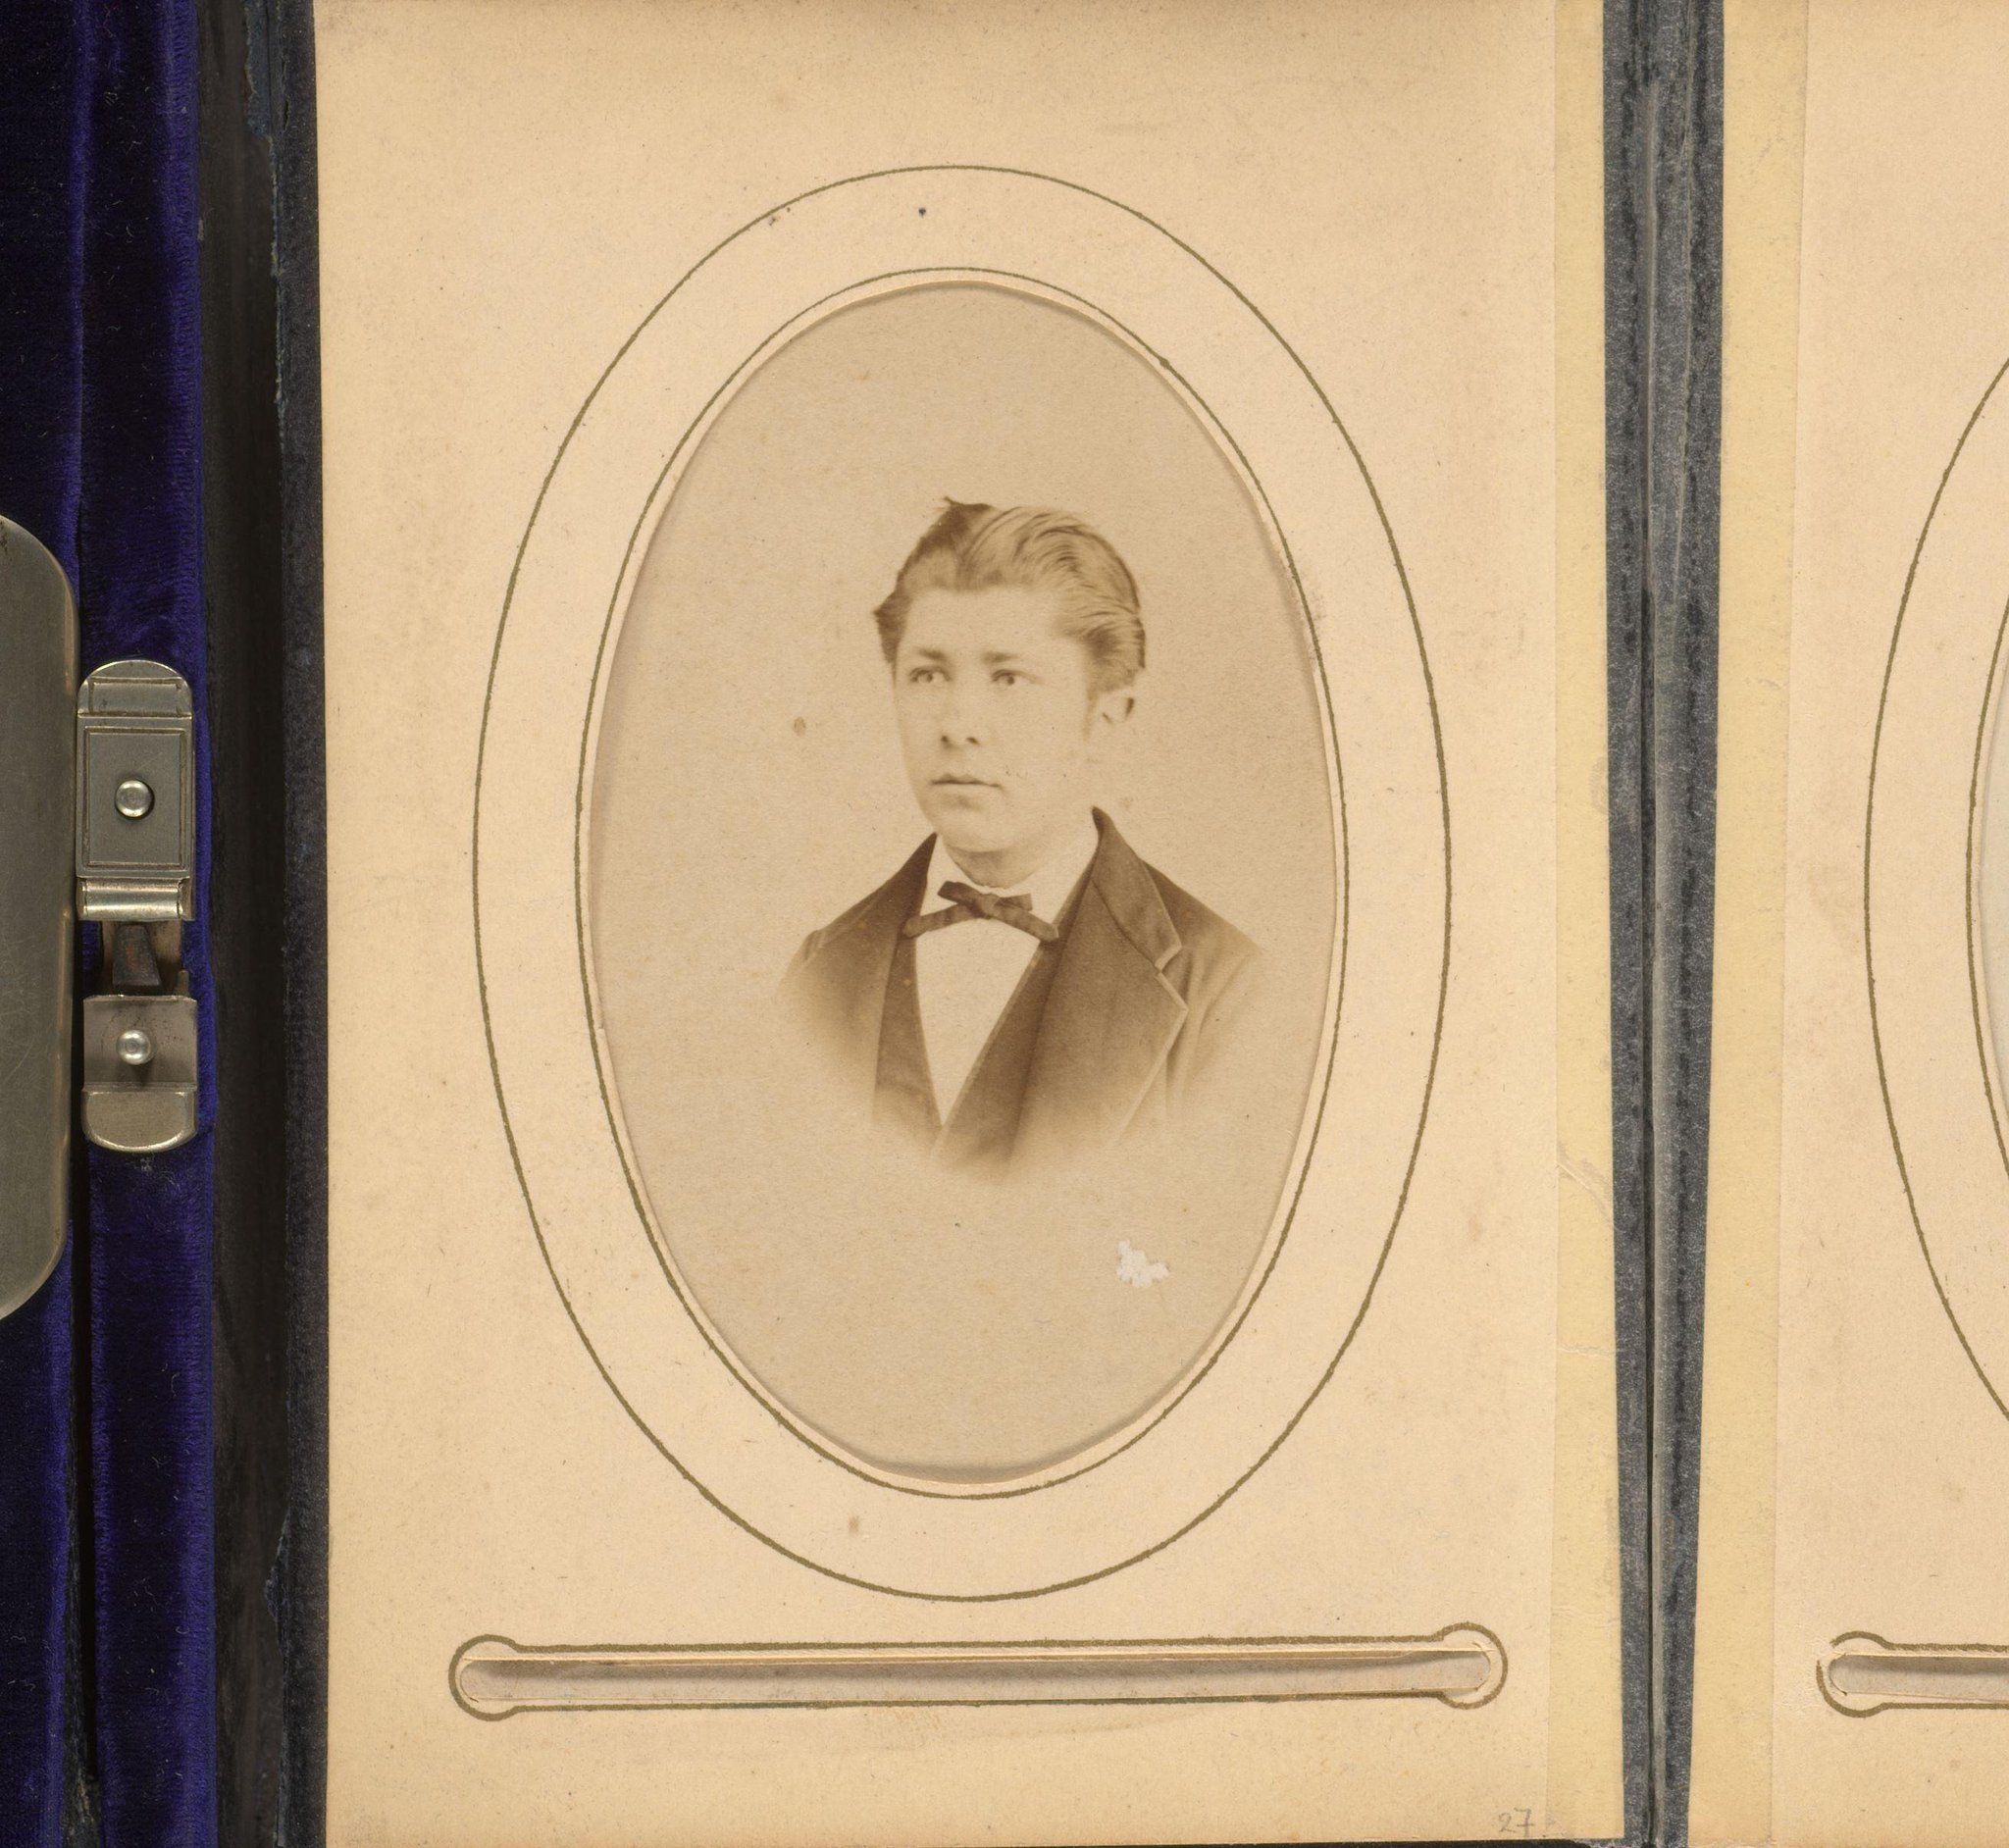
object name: photograph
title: Portret van een jongen met vlinderstrik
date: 1863-1899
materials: cardboard, photographic support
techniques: albumen print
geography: delft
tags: boy (child between toddler and youth), historical persons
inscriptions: inscription: ‘Photographisches Atelier/ E. KIRCHNER & Co./ DELFT.’